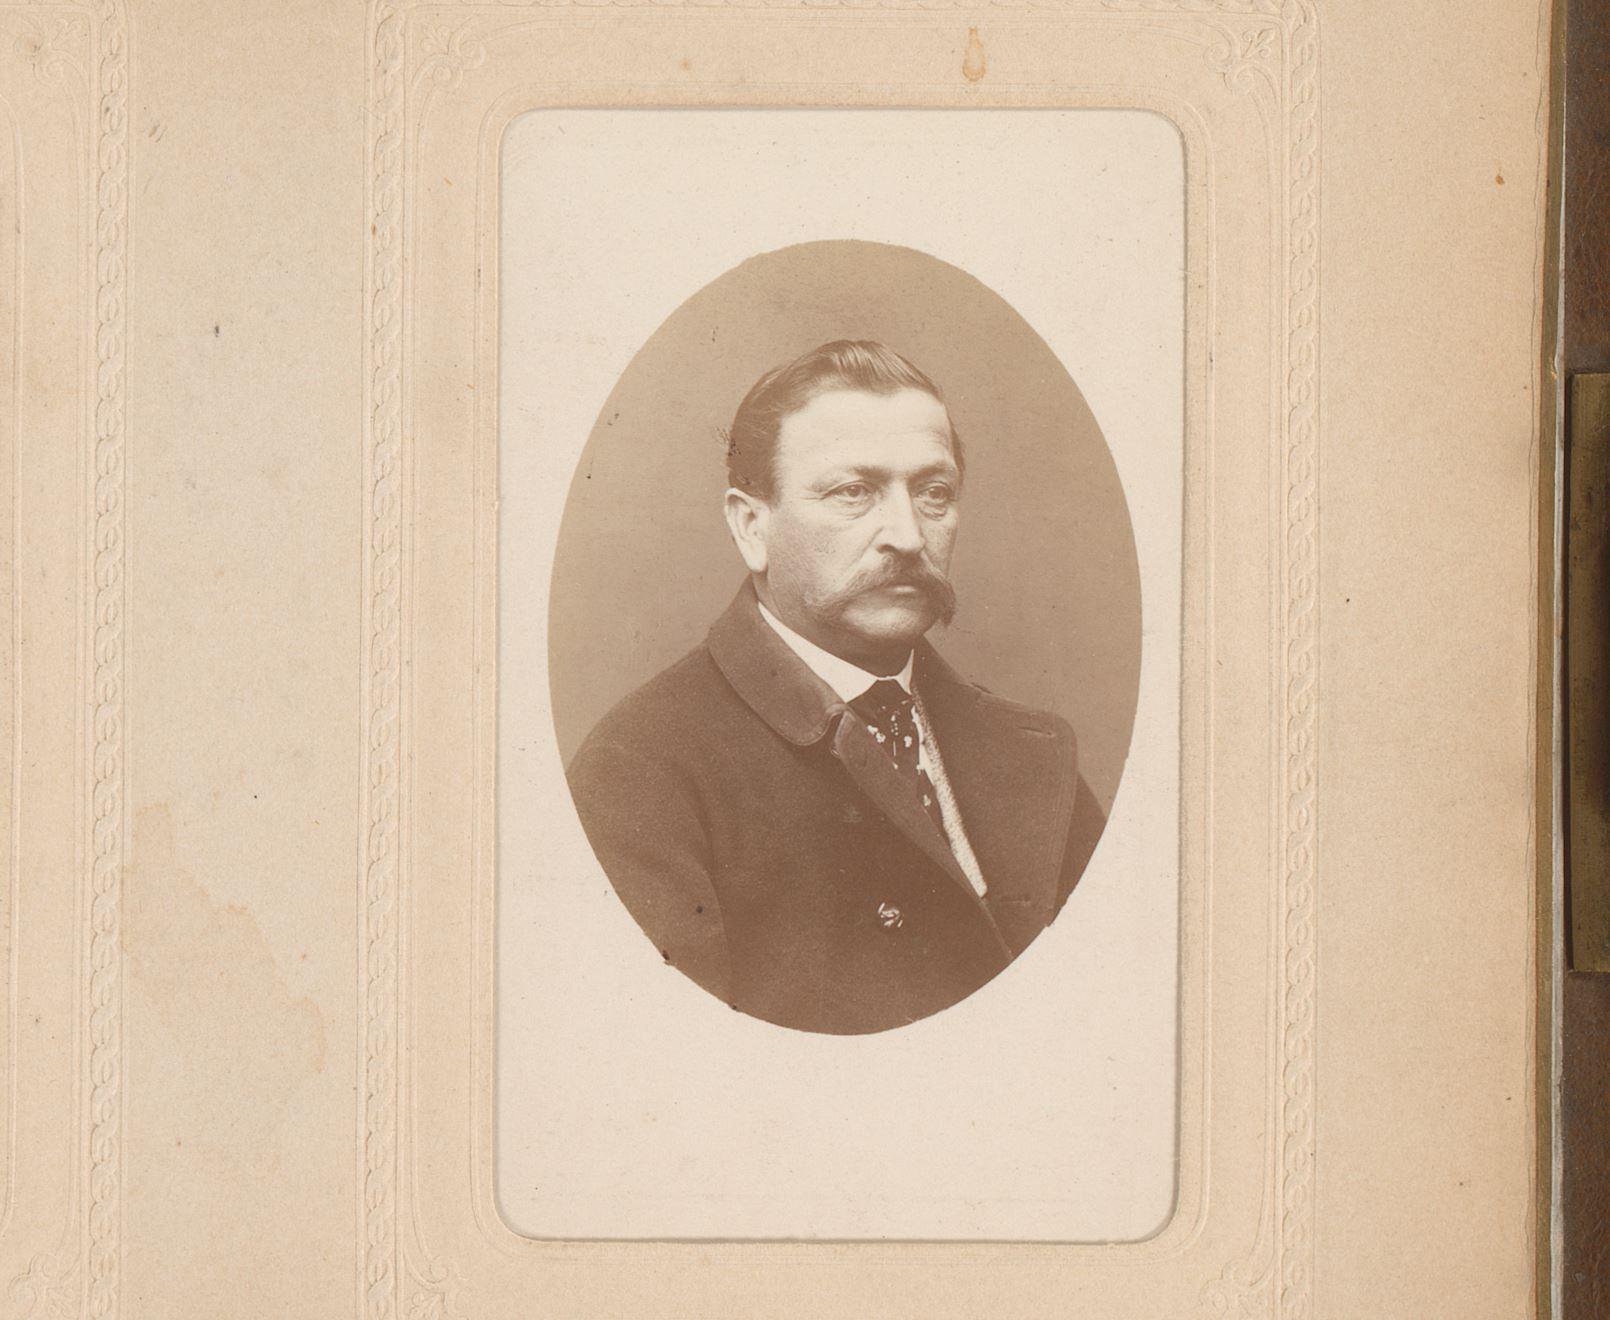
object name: photograph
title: Portret van een man met snor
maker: heinrich dittrich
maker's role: fotograaf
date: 1860-1900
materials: cardboard, photographic support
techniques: albumen print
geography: kutná hora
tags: moustache, historical persons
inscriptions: inscription: ‘H. DITTRICH/ FOTOGRAF/ Kutná Hora/ zeleny trb./ Kuttenberg/ Grünmarkt.’